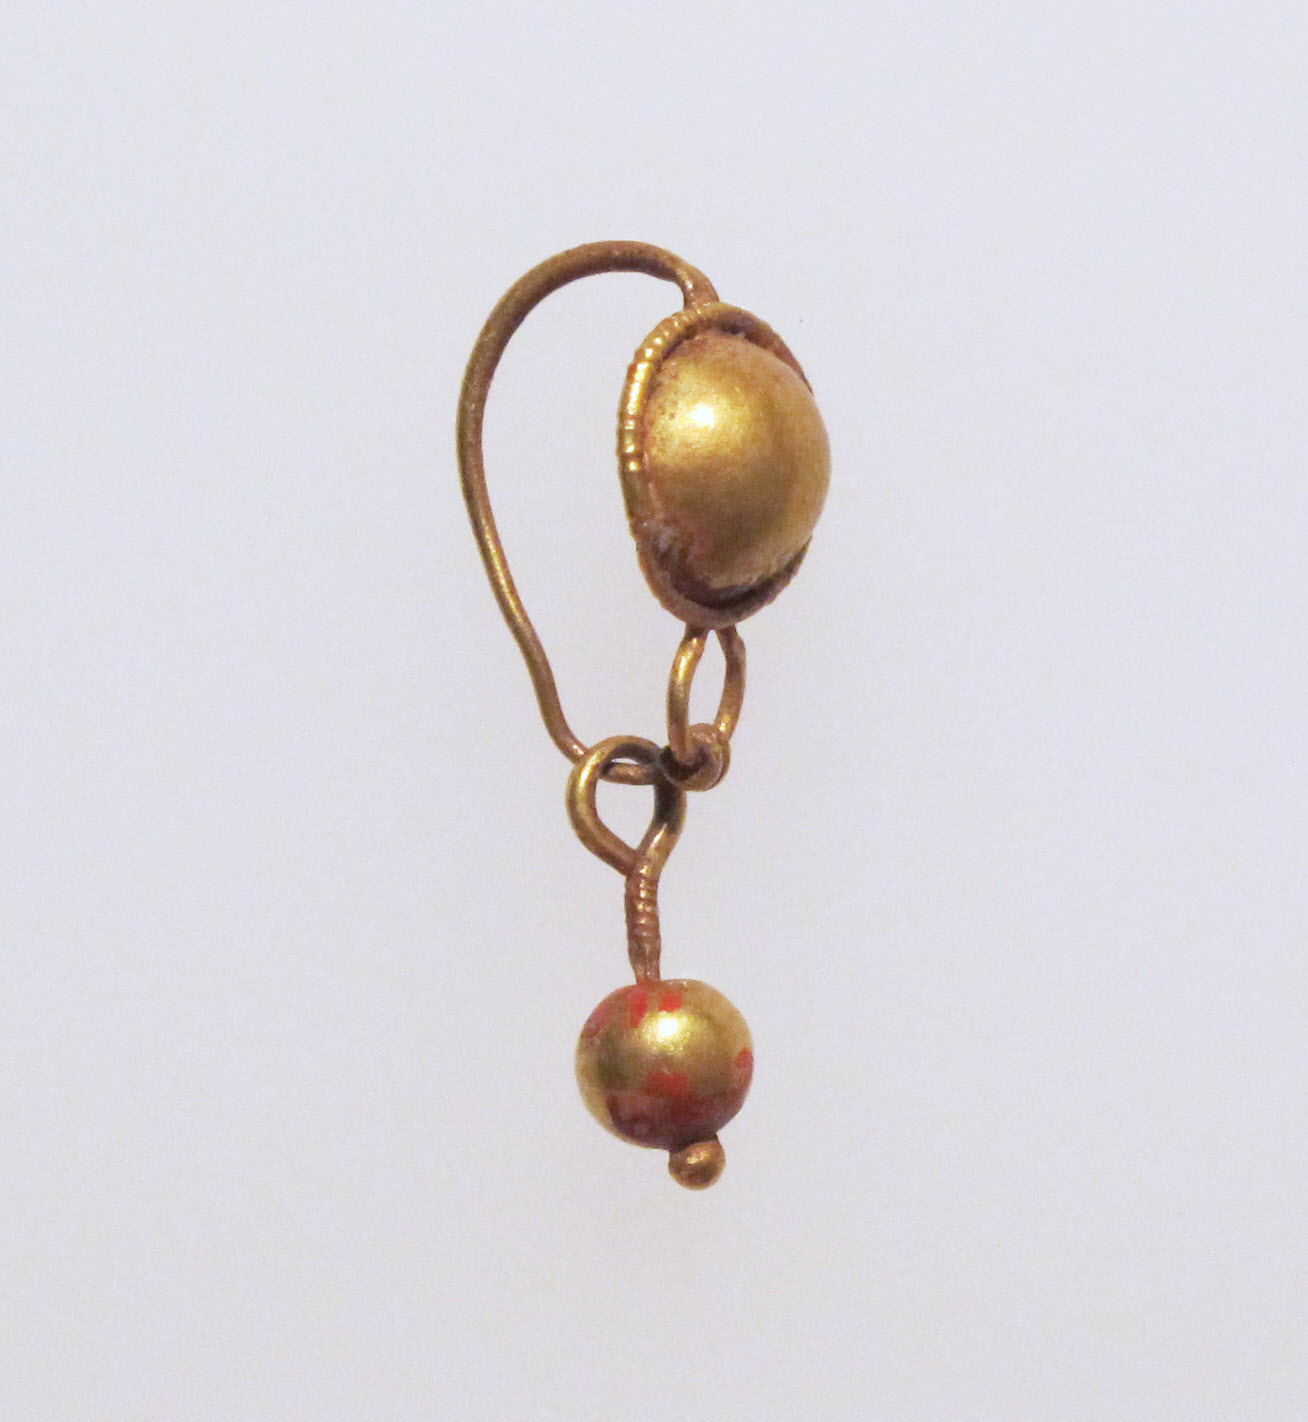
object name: earring with pendant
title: Gold earring with disc and pendant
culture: roman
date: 101-200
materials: gold